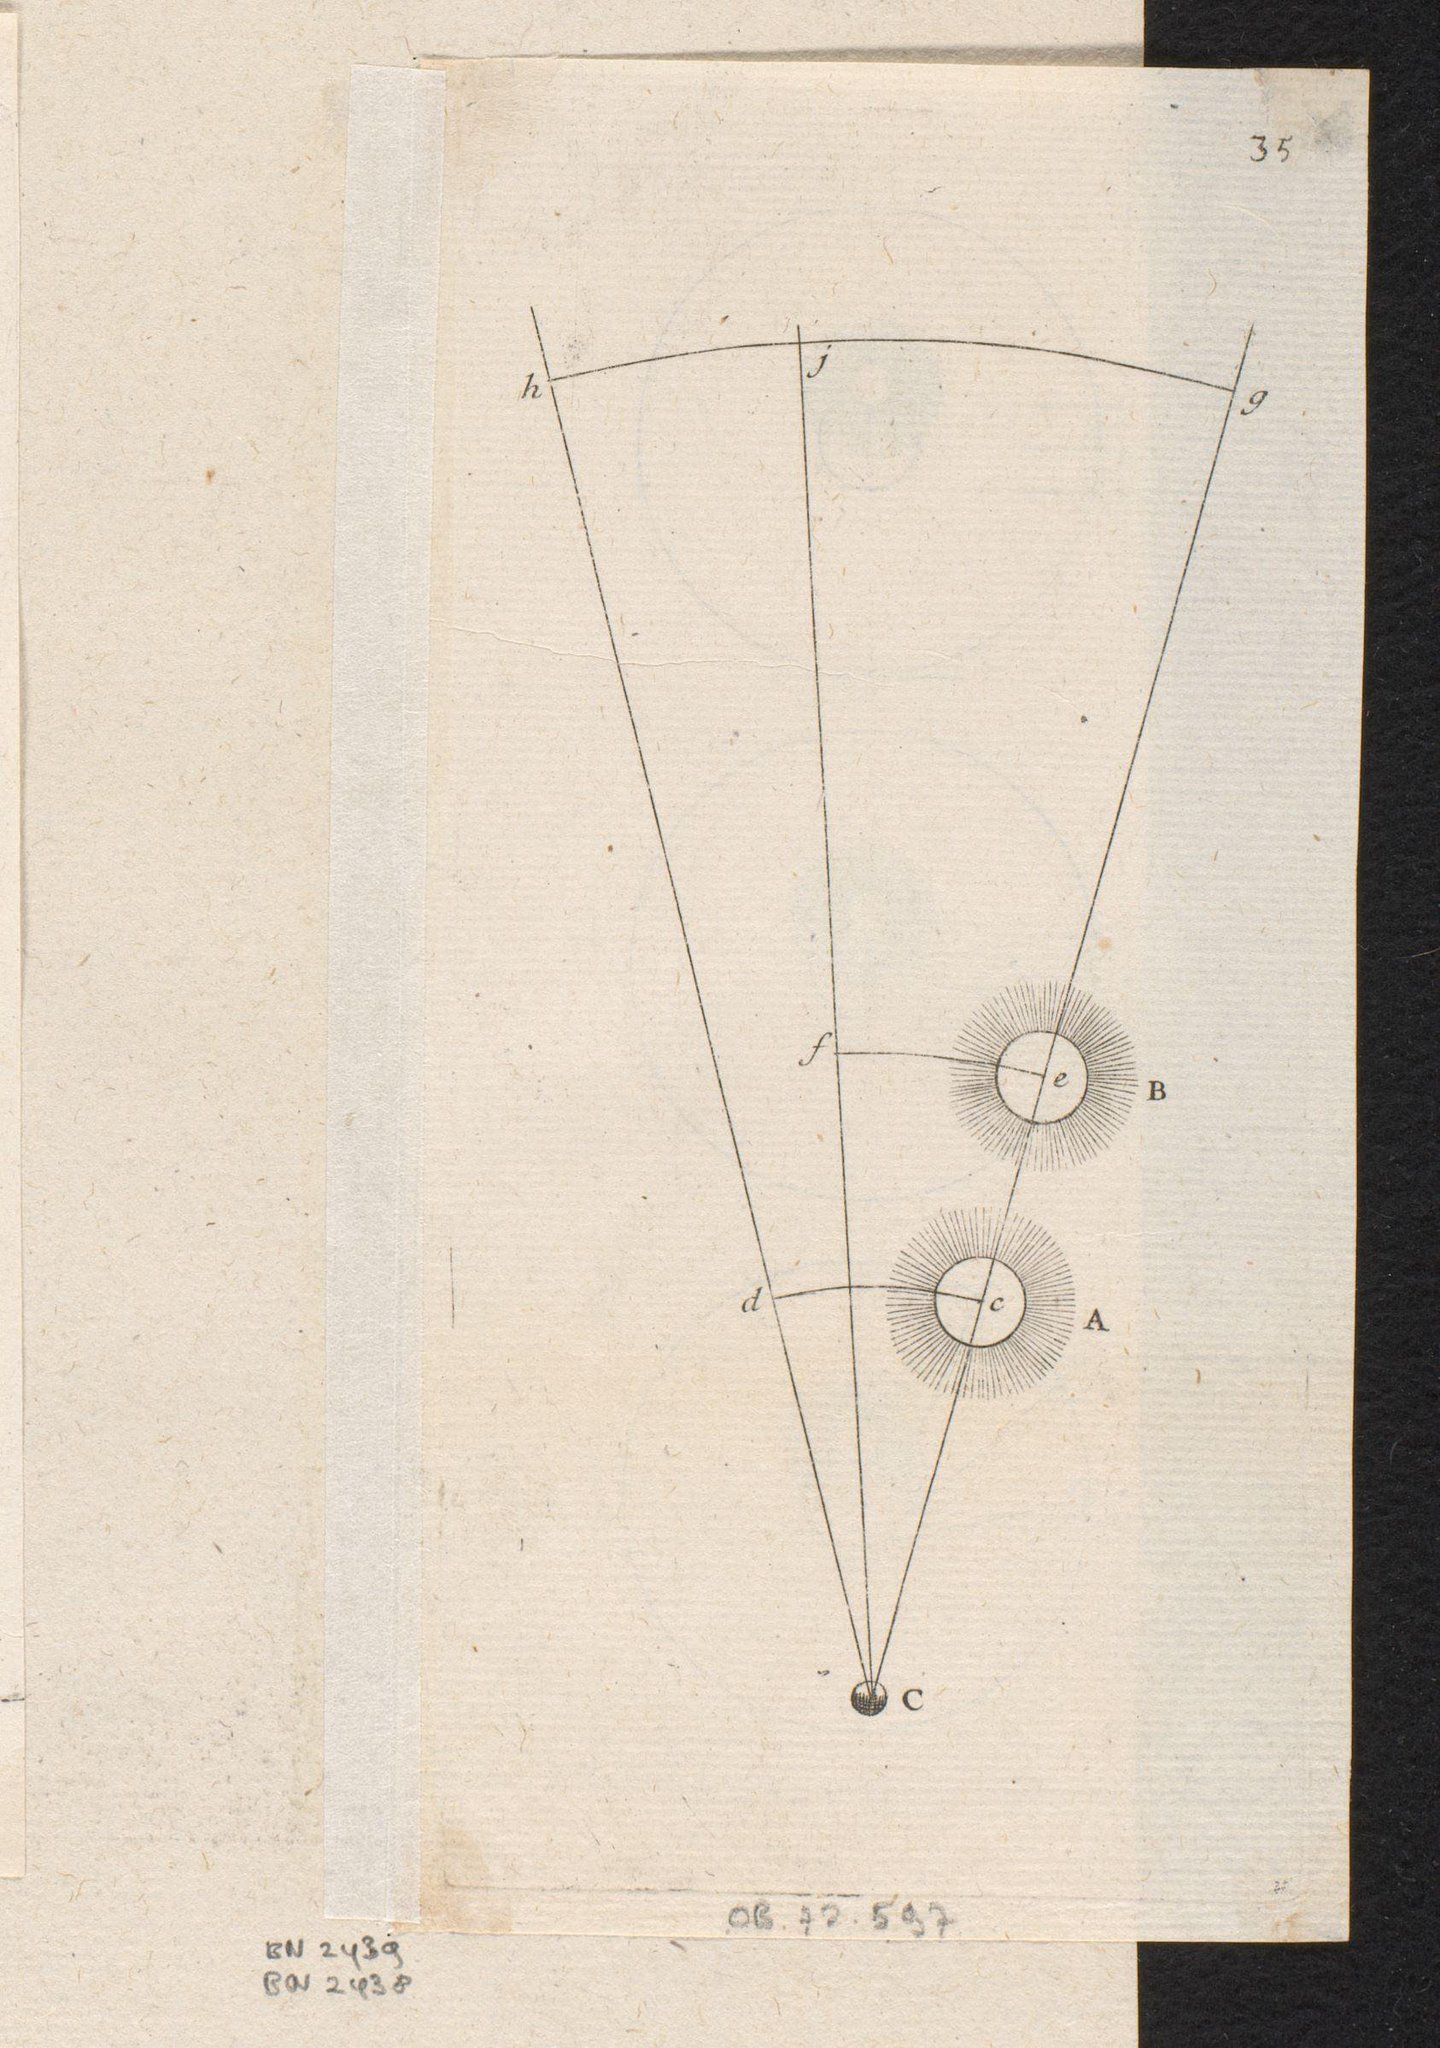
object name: book illustration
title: Zon lijkt sneller te draaien rond de Aarde in de winter dan in de zomer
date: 1706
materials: paper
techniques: etching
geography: france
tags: earth, world as celestial body, summer, 'aestas'; 'estate' (ripa), winter, 'hyems'; 'inverno' (ripa), sun as celestial body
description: Prent uit: Leclerc, Sébastien. Nouveau systeme du monde conforme à l'Ecriture sainte. Où les phénomènes sont expliquez sans excentricité de mouvement (...). Paris: Pierre Giffart, 1706.